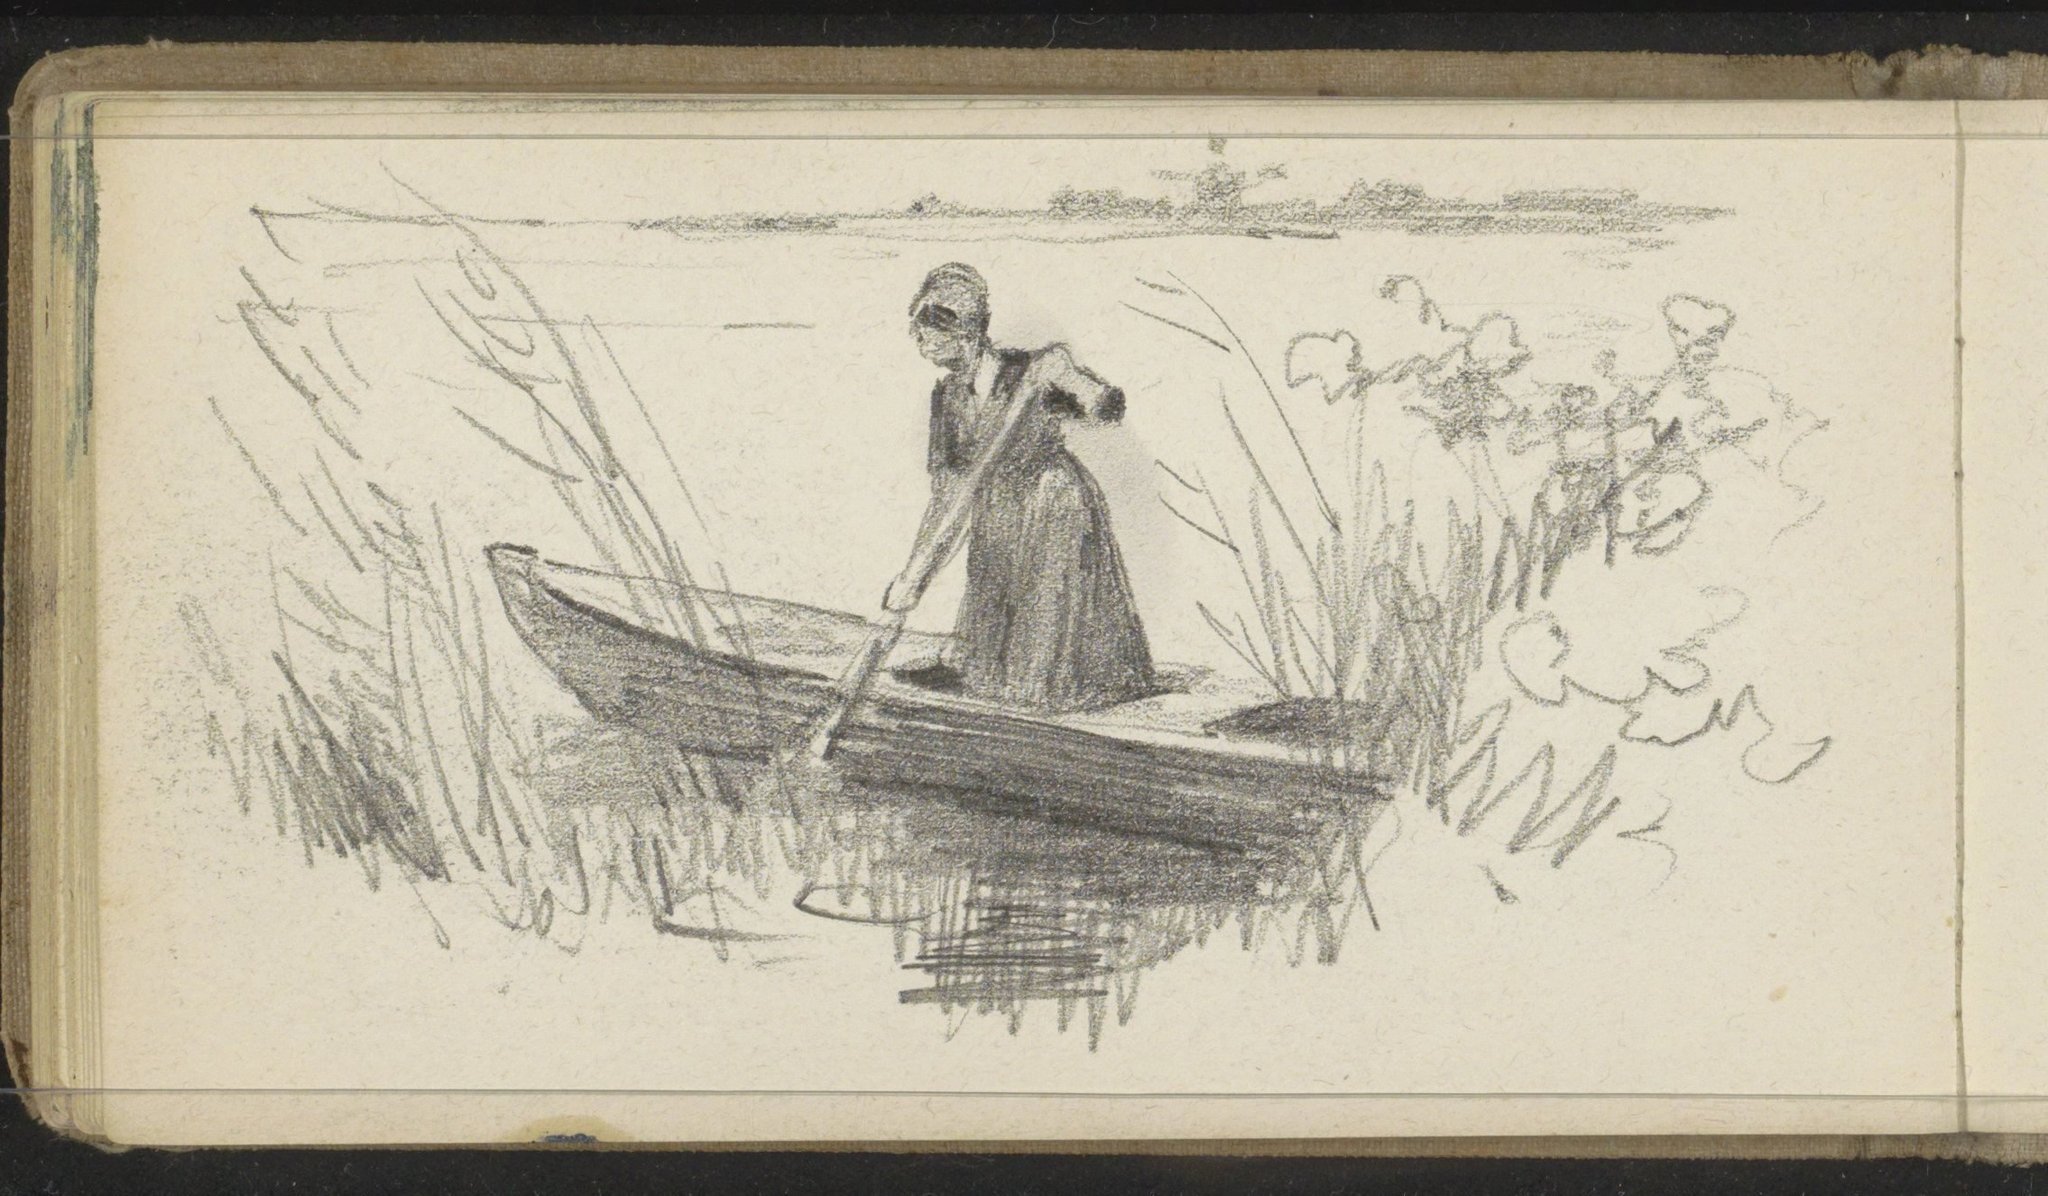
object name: sketchbook leaf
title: Vrouw in een roeiboot bij een waterkant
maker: willem cornelis rip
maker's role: draughtsman, painter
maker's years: 1856-1922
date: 1895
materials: paper, pencil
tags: rowing-boat, canoe, etc., landscapes with waters, waterscapes, seascapes (in the temperate zone) (+ landscape with figures, staffage)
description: Blad 36 verso uit een schetsboek met 39 bladen.